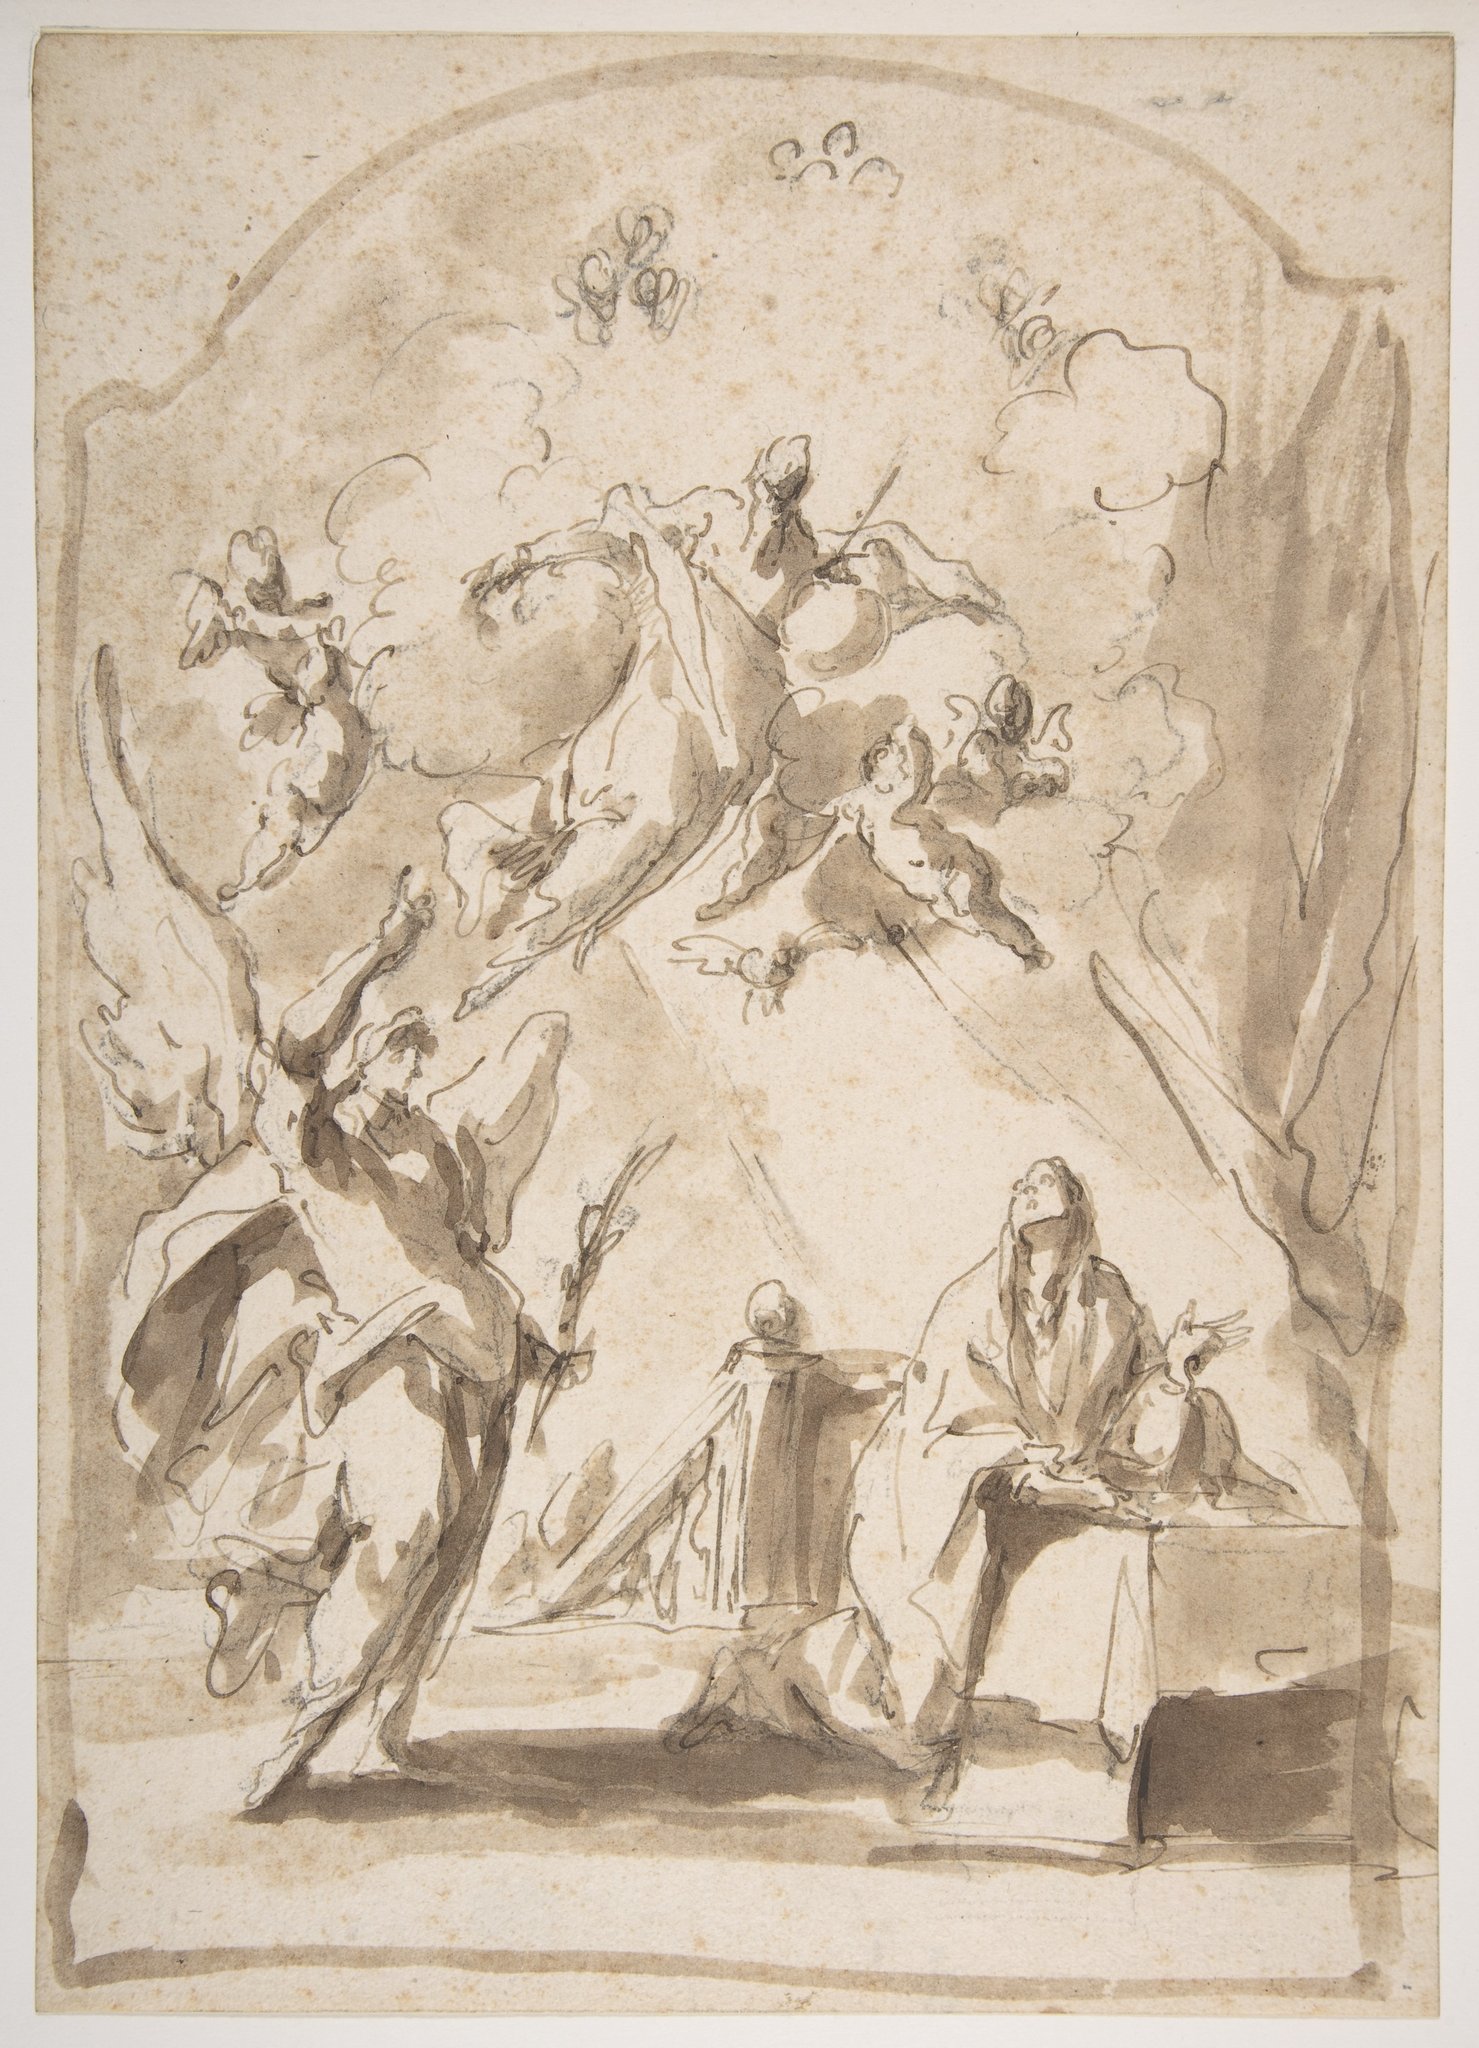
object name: drawing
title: The Annunciation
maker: giovanni antonio pellegrini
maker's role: artist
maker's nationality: italian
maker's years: 1675-1741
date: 1675-1741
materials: graphite, ink, lead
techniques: brush, pen, wash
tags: annunciation